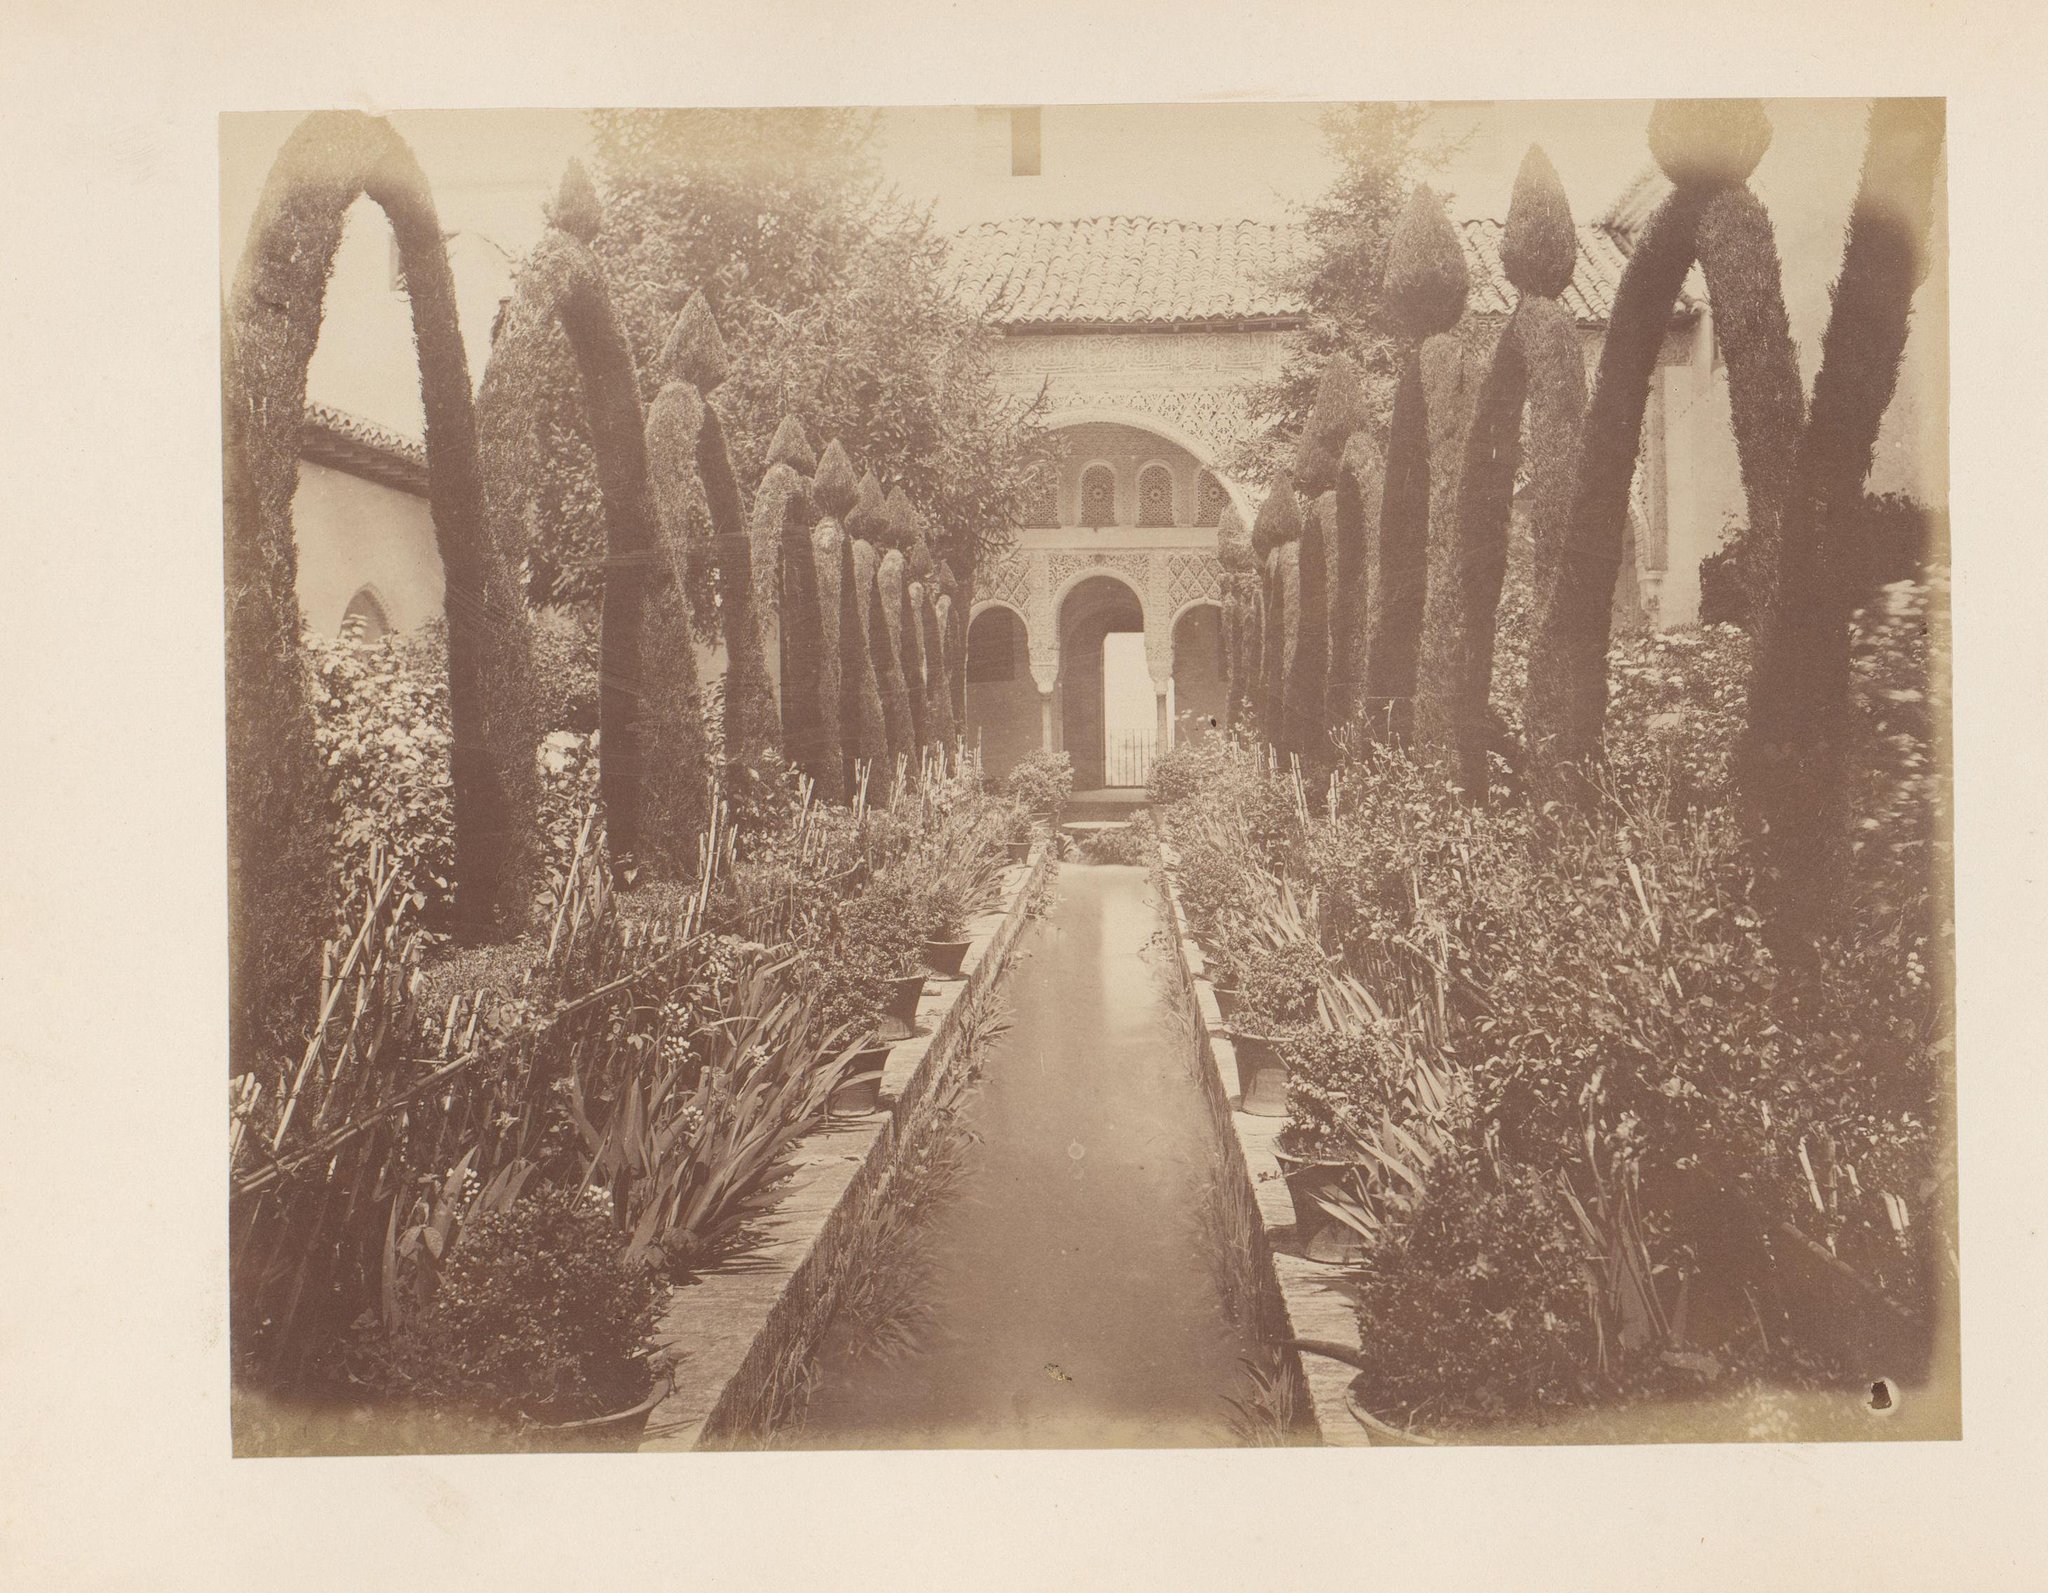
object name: album leaf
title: Jardin del generalife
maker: c maufsaise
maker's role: fotograaf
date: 1906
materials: paper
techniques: albumen print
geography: granada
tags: garden, palace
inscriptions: number: ‘70’